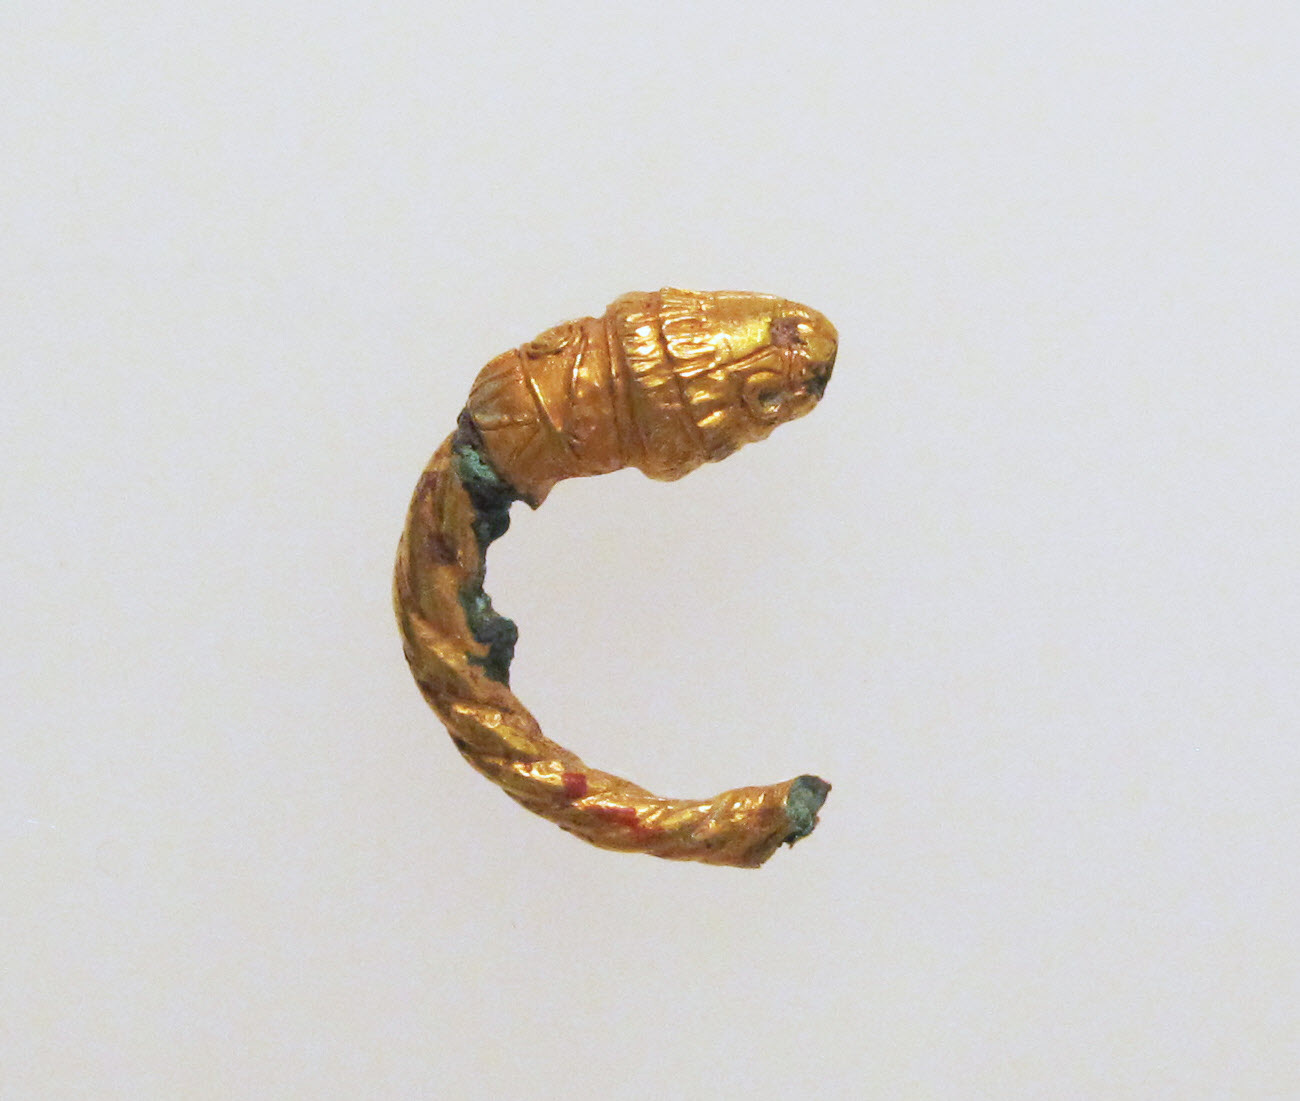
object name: earring with head of lion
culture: greek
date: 400-201 BCE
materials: gold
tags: lions